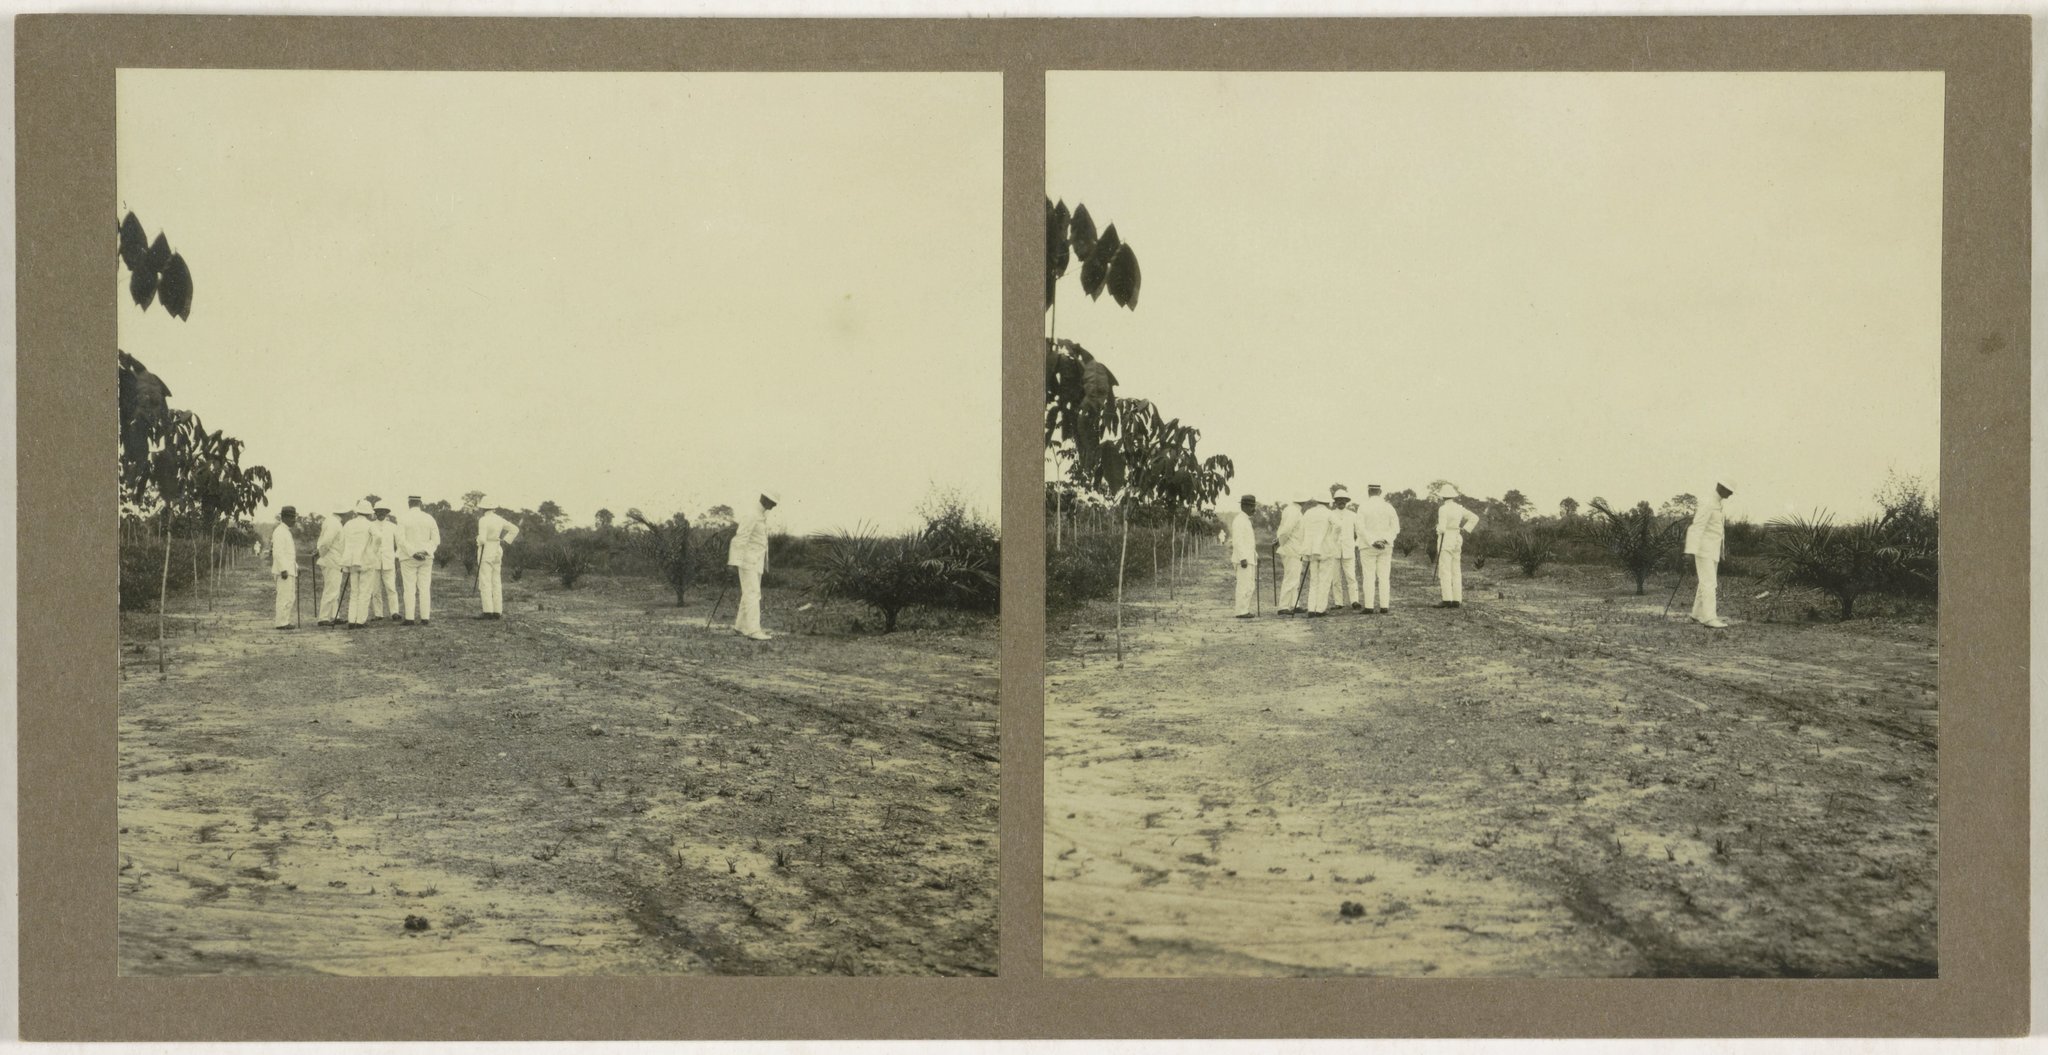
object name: stereograph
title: Zeven mannen op een landweg, mogelijk op Borneo, Indonesië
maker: Anonymous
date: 1900-1940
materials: paper, cardboard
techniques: gelatin silver print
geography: indonesia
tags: adult man (+ seven persons), indonesia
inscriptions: inscription: ‘onderneming oliepalmen en/ Hevea van Hanflaud/ van Gn. Kalpang [?]’